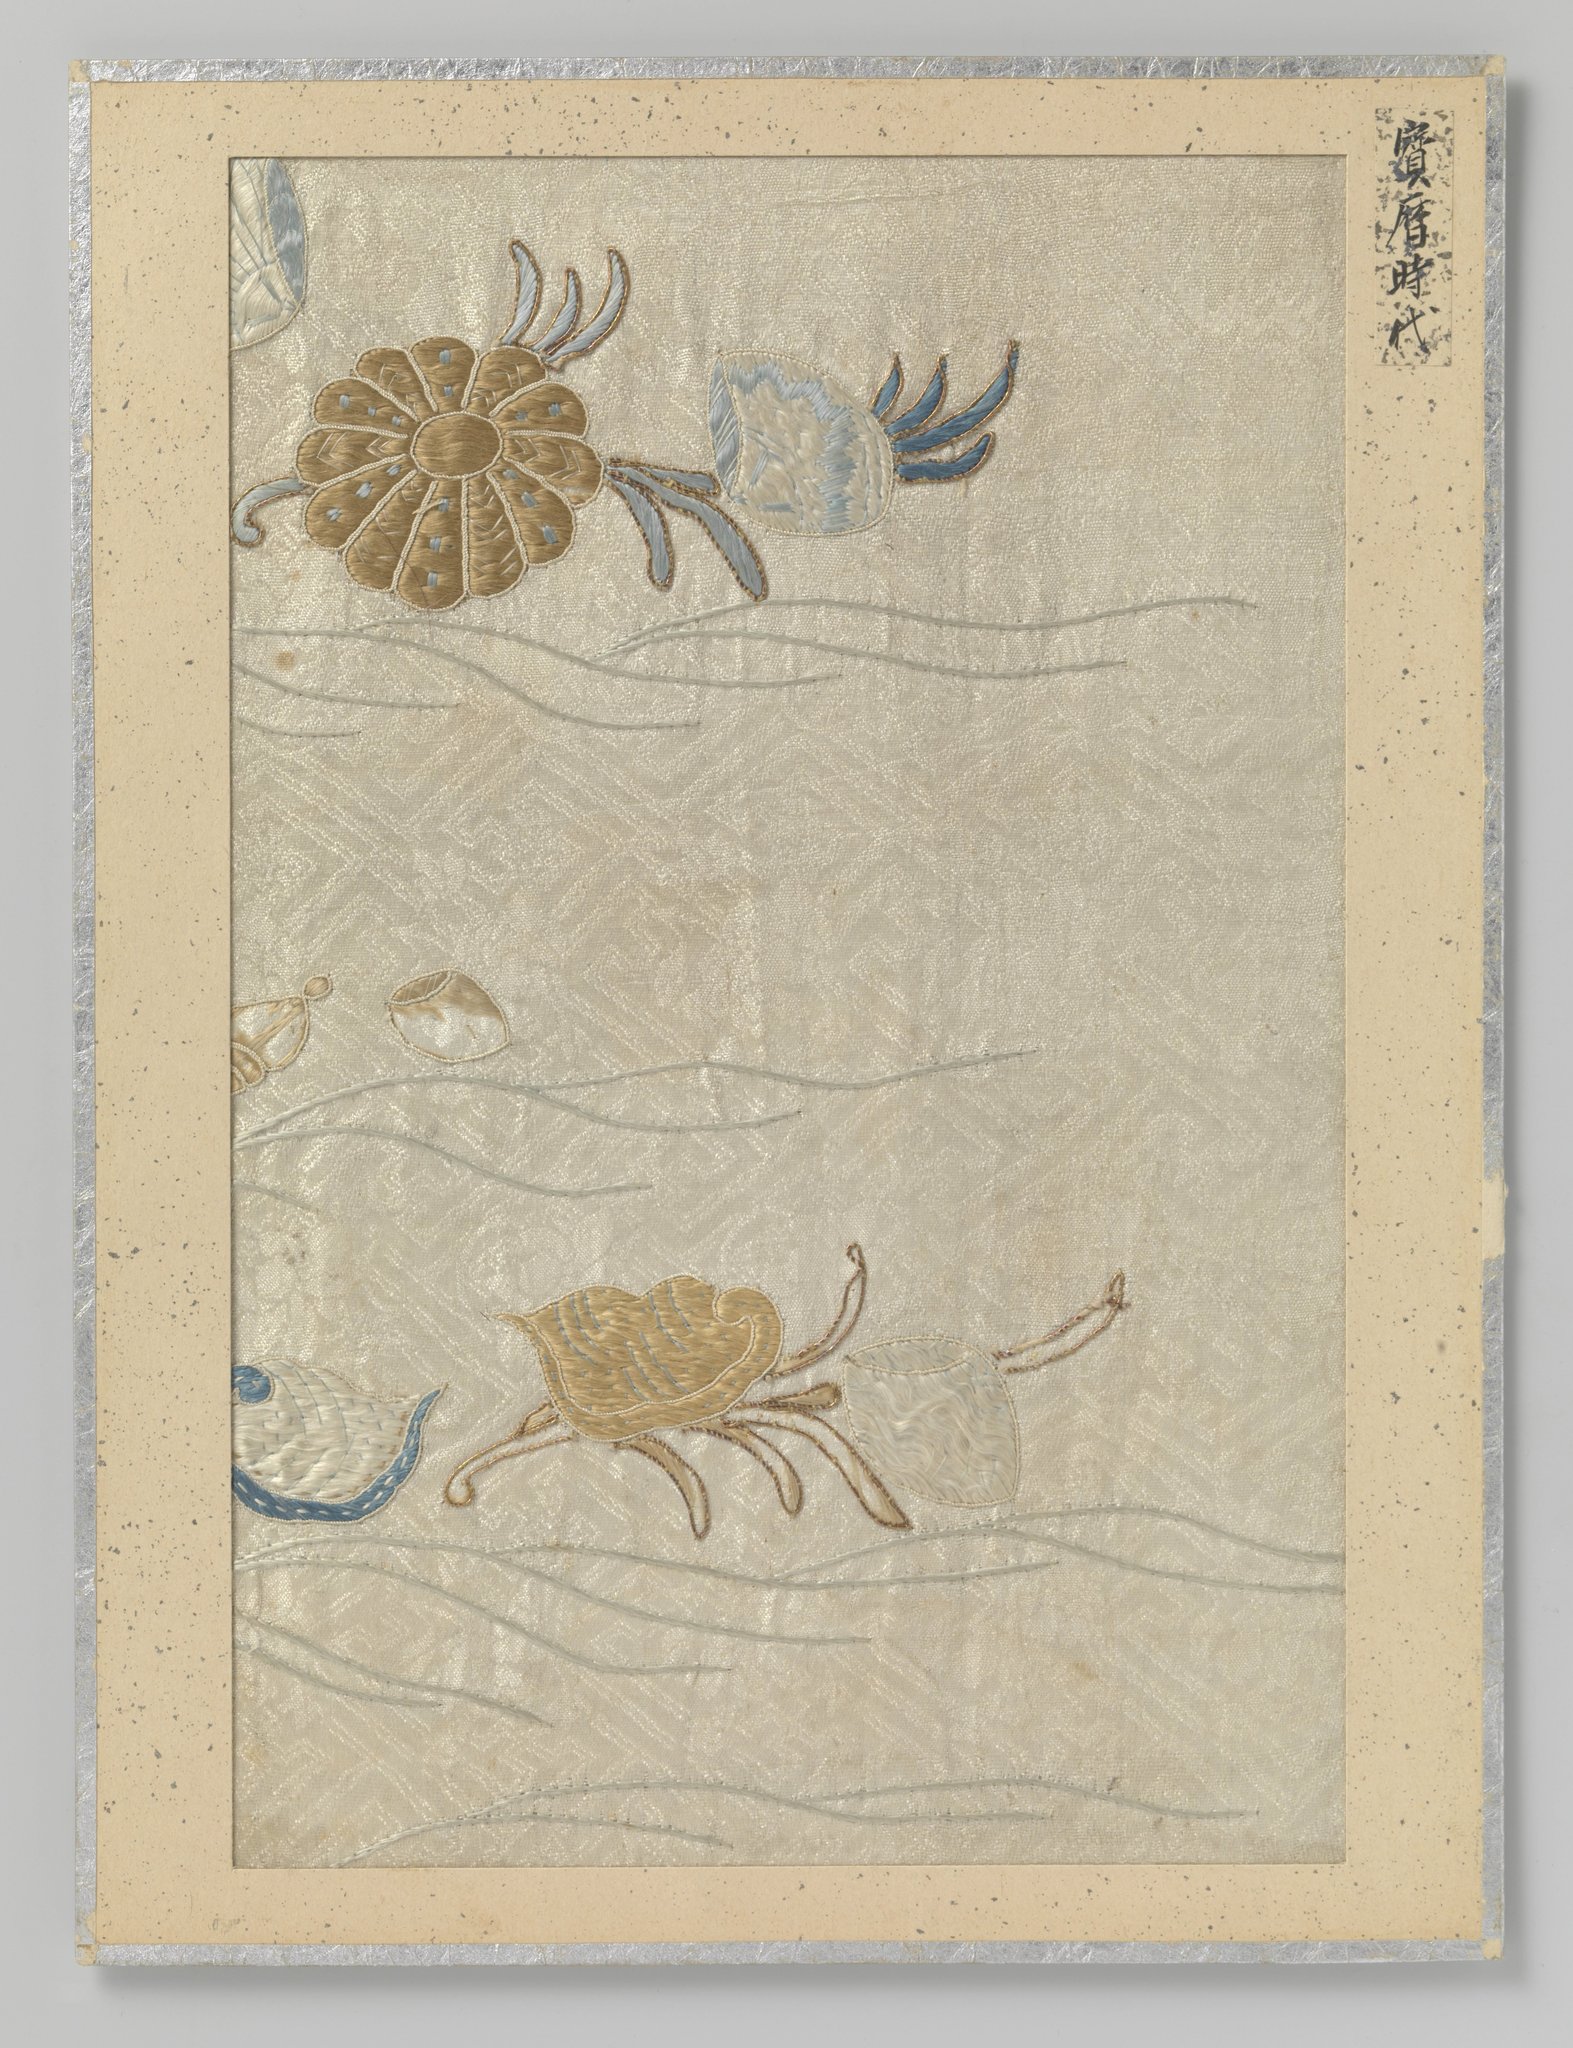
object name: fragment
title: Textielfragment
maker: Anonymous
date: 1751-1764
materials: silk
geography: japan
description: Textielfragment, borduursel van bloemen en schelpdieren op witte damast achtergrond.